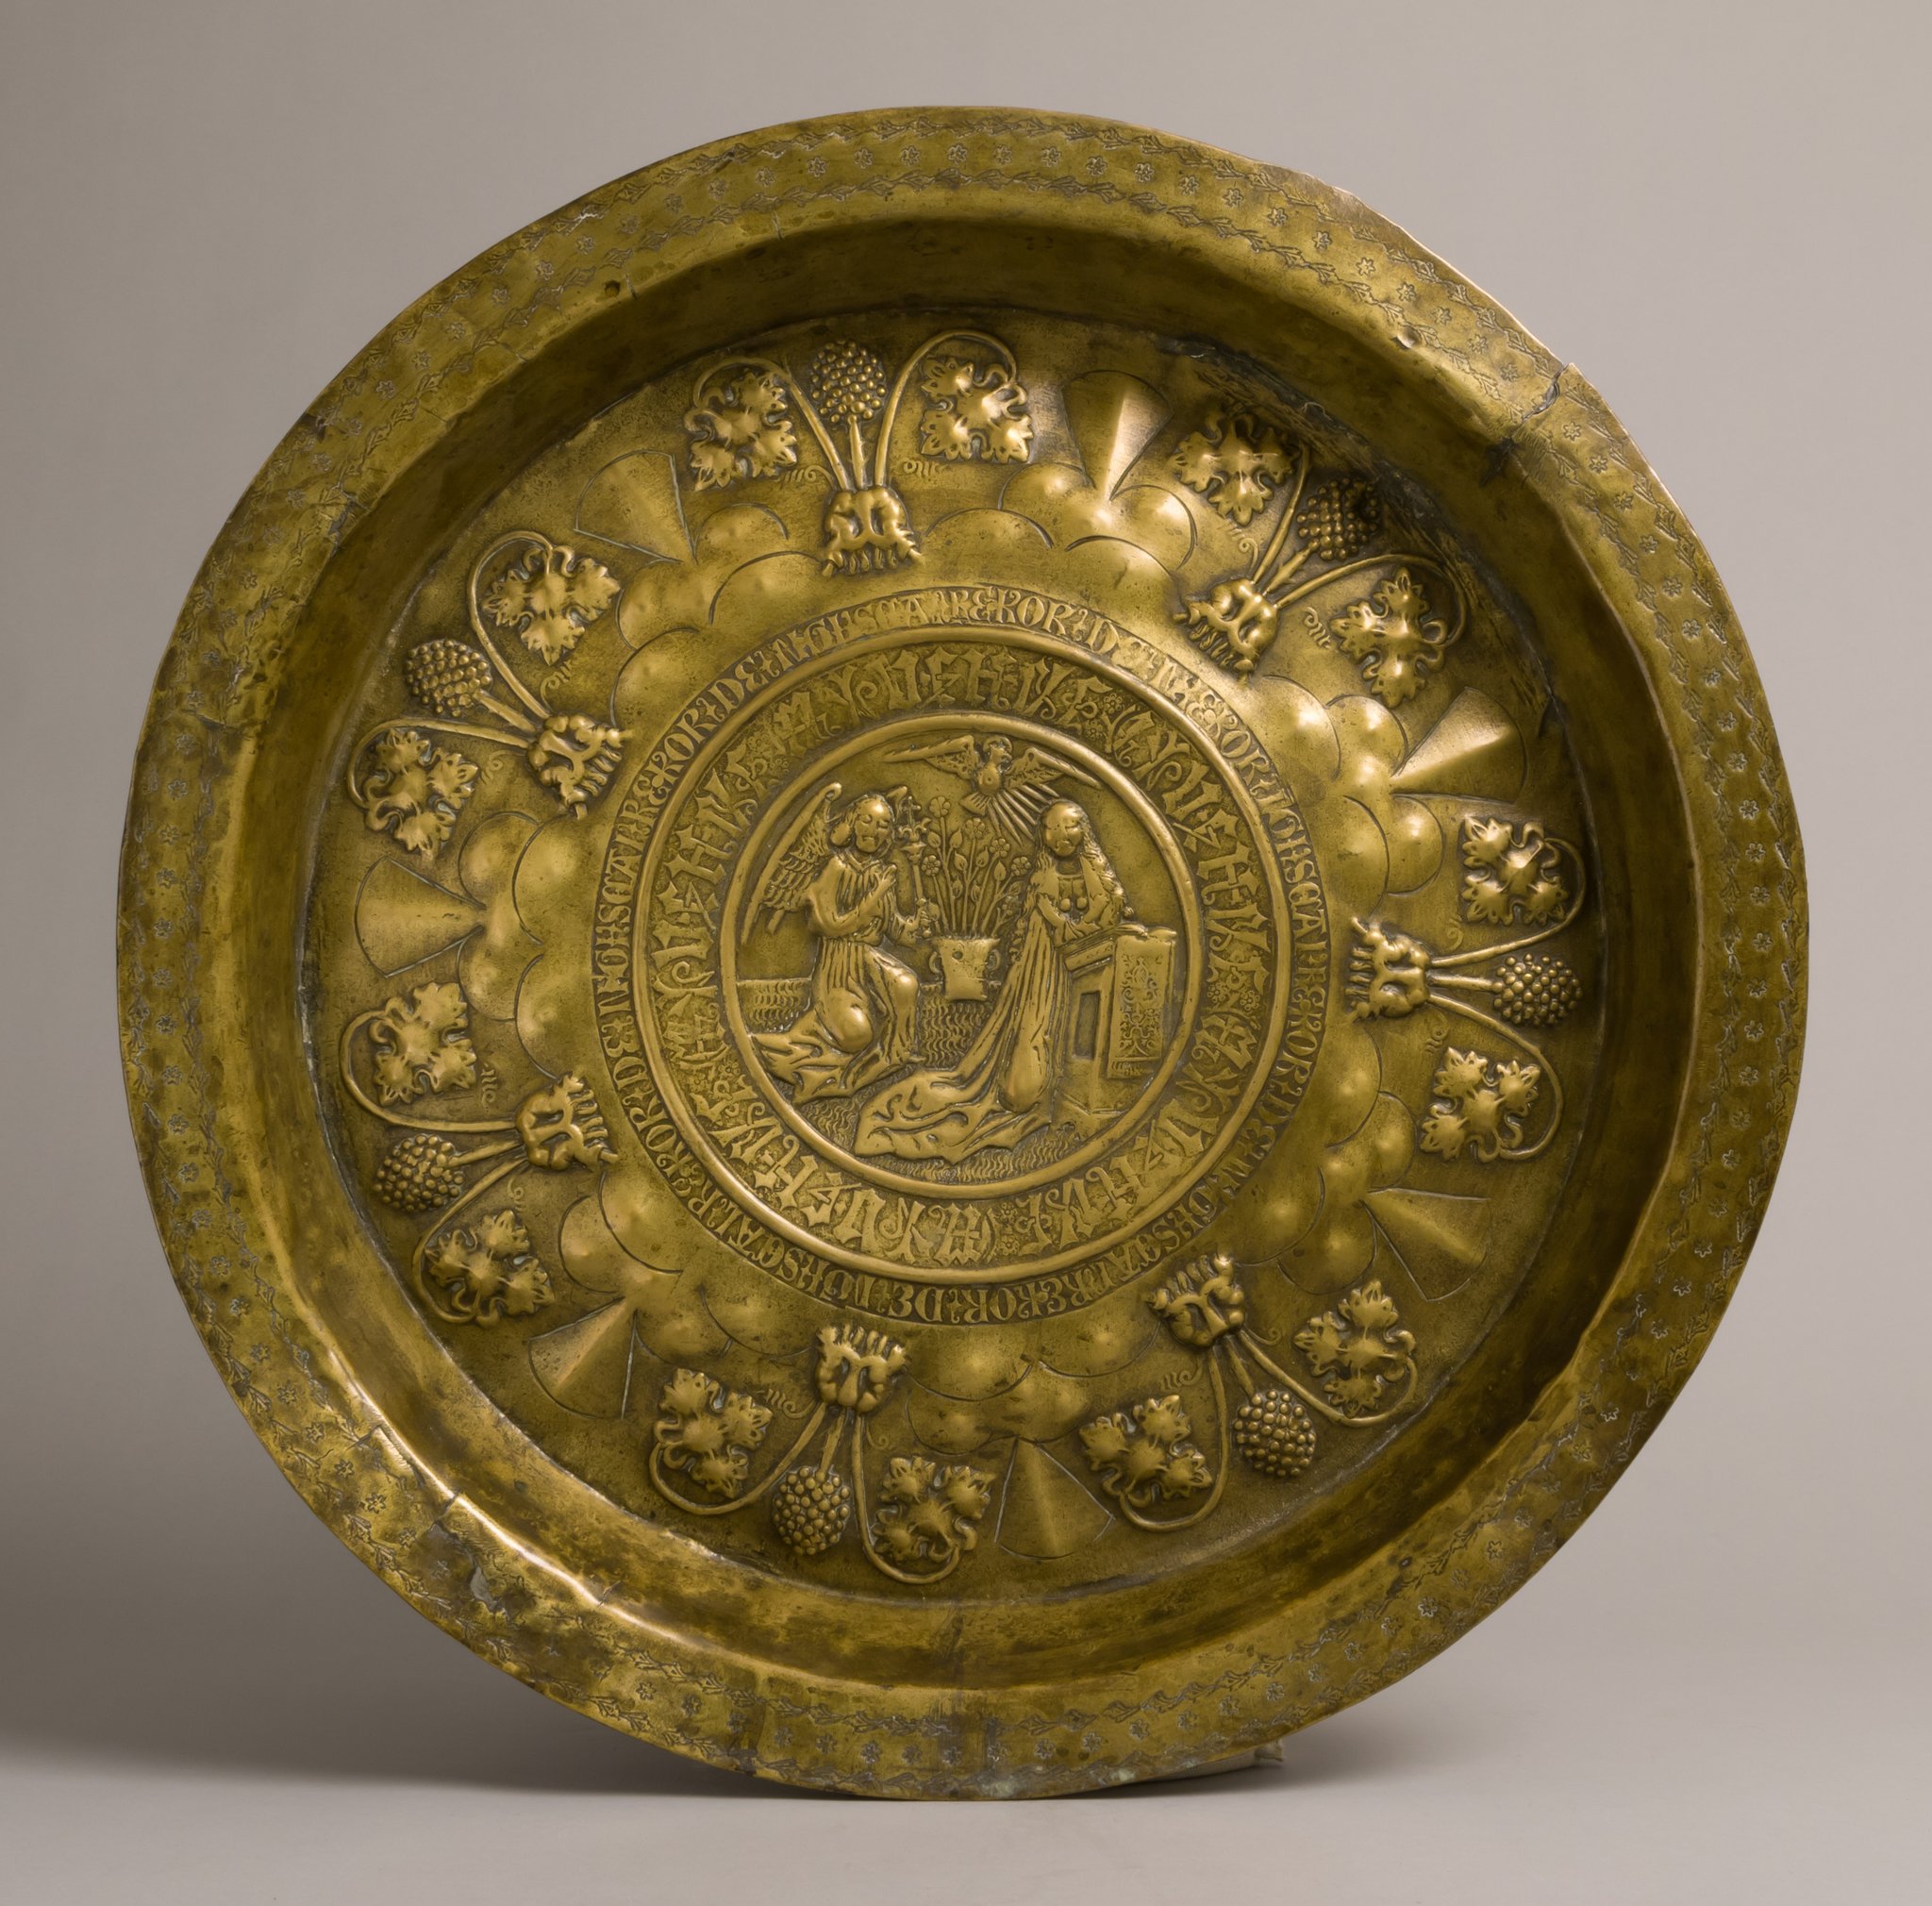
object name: plate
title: Plate, The Annunciation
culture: german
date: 1467-1500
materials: brass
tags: birds,angels,virgin mary